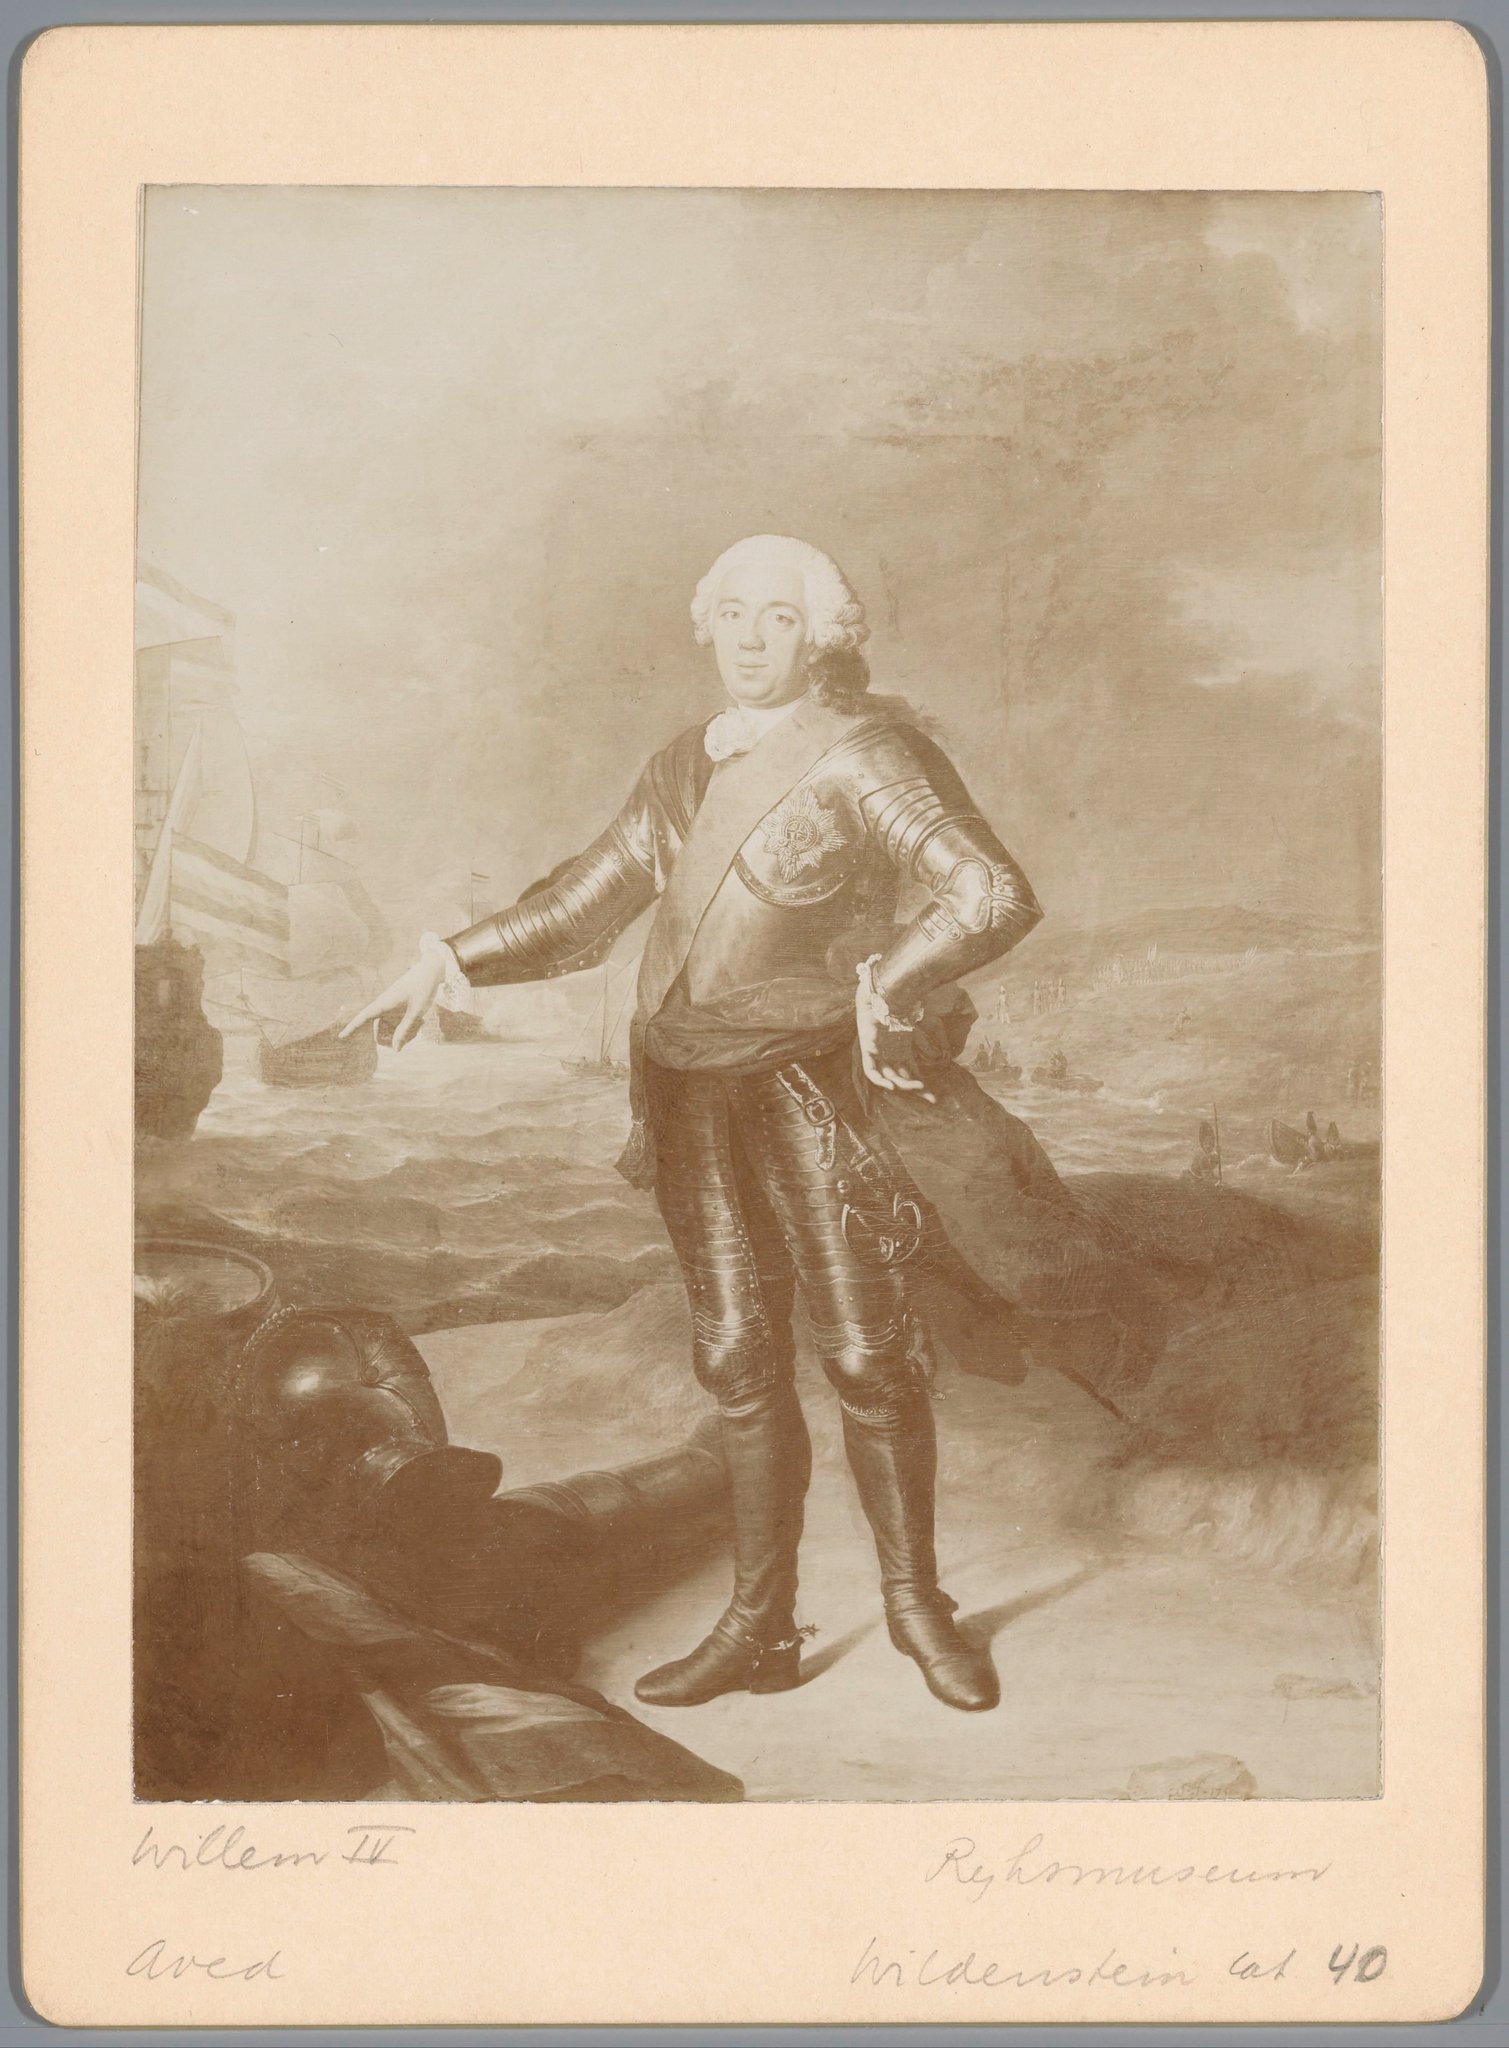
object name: photograph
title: Fotoreproductie van een geschilderd portret van Willem IV, prins van Oranje-Nassau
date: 1880-1910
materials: paper, cardboard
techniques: collodion silver print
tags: the hague, willem iv (prins van oranje-nassau), prince, historical persons, beach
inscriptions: inscription: ‘Aved’, inscription: ‘Willem IV/ Rijksmuseum/ Aved/ Wildestein cat 40’